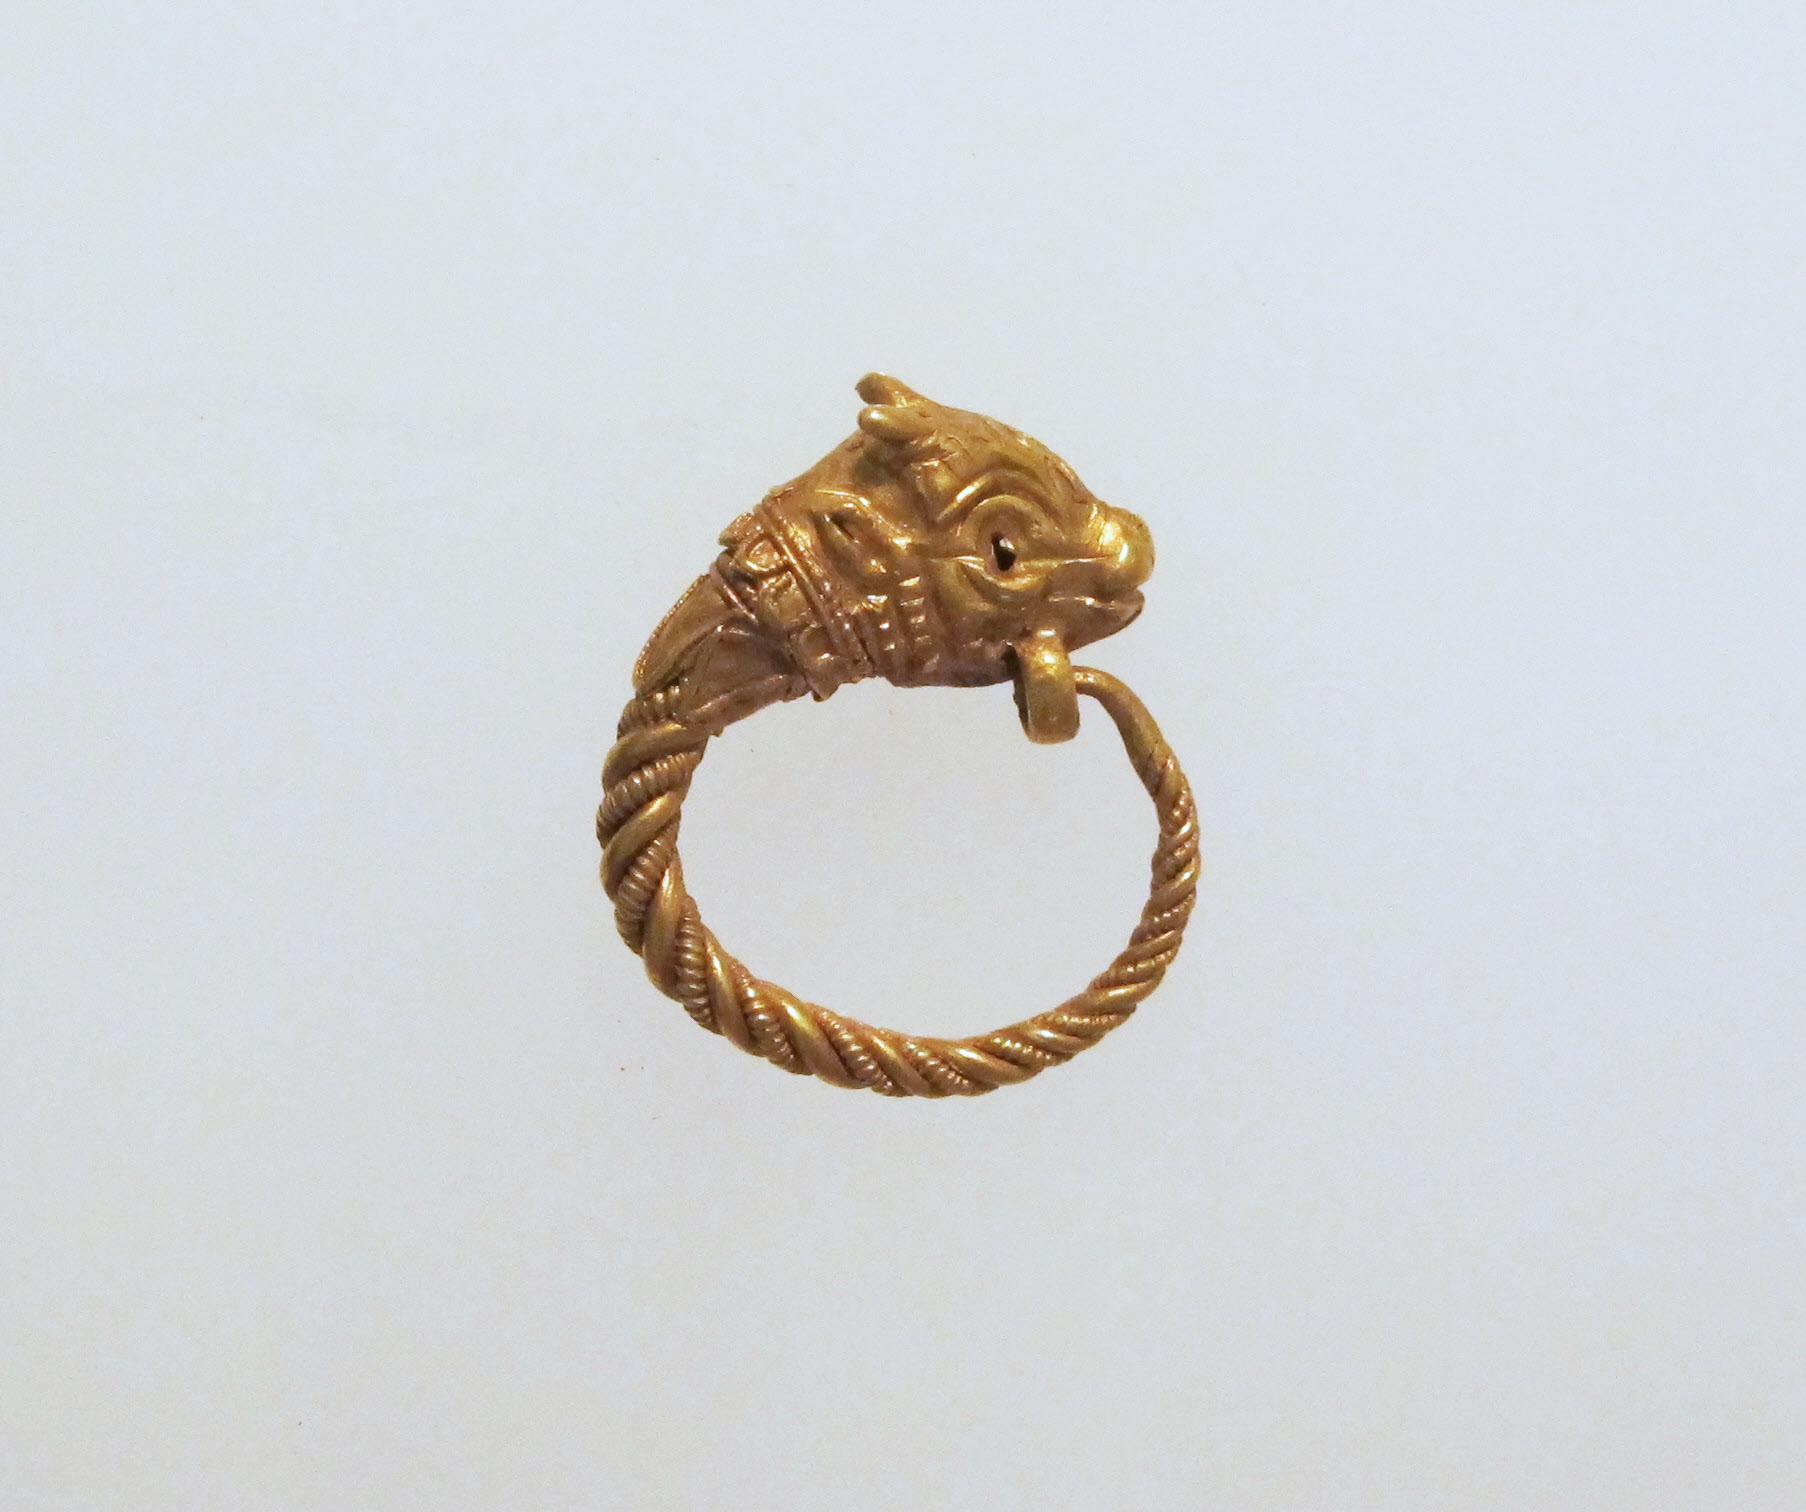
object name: earring with head of bull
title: Gold earring with head of a bull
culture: greek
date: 400-201 BCE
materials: gold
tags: bulls